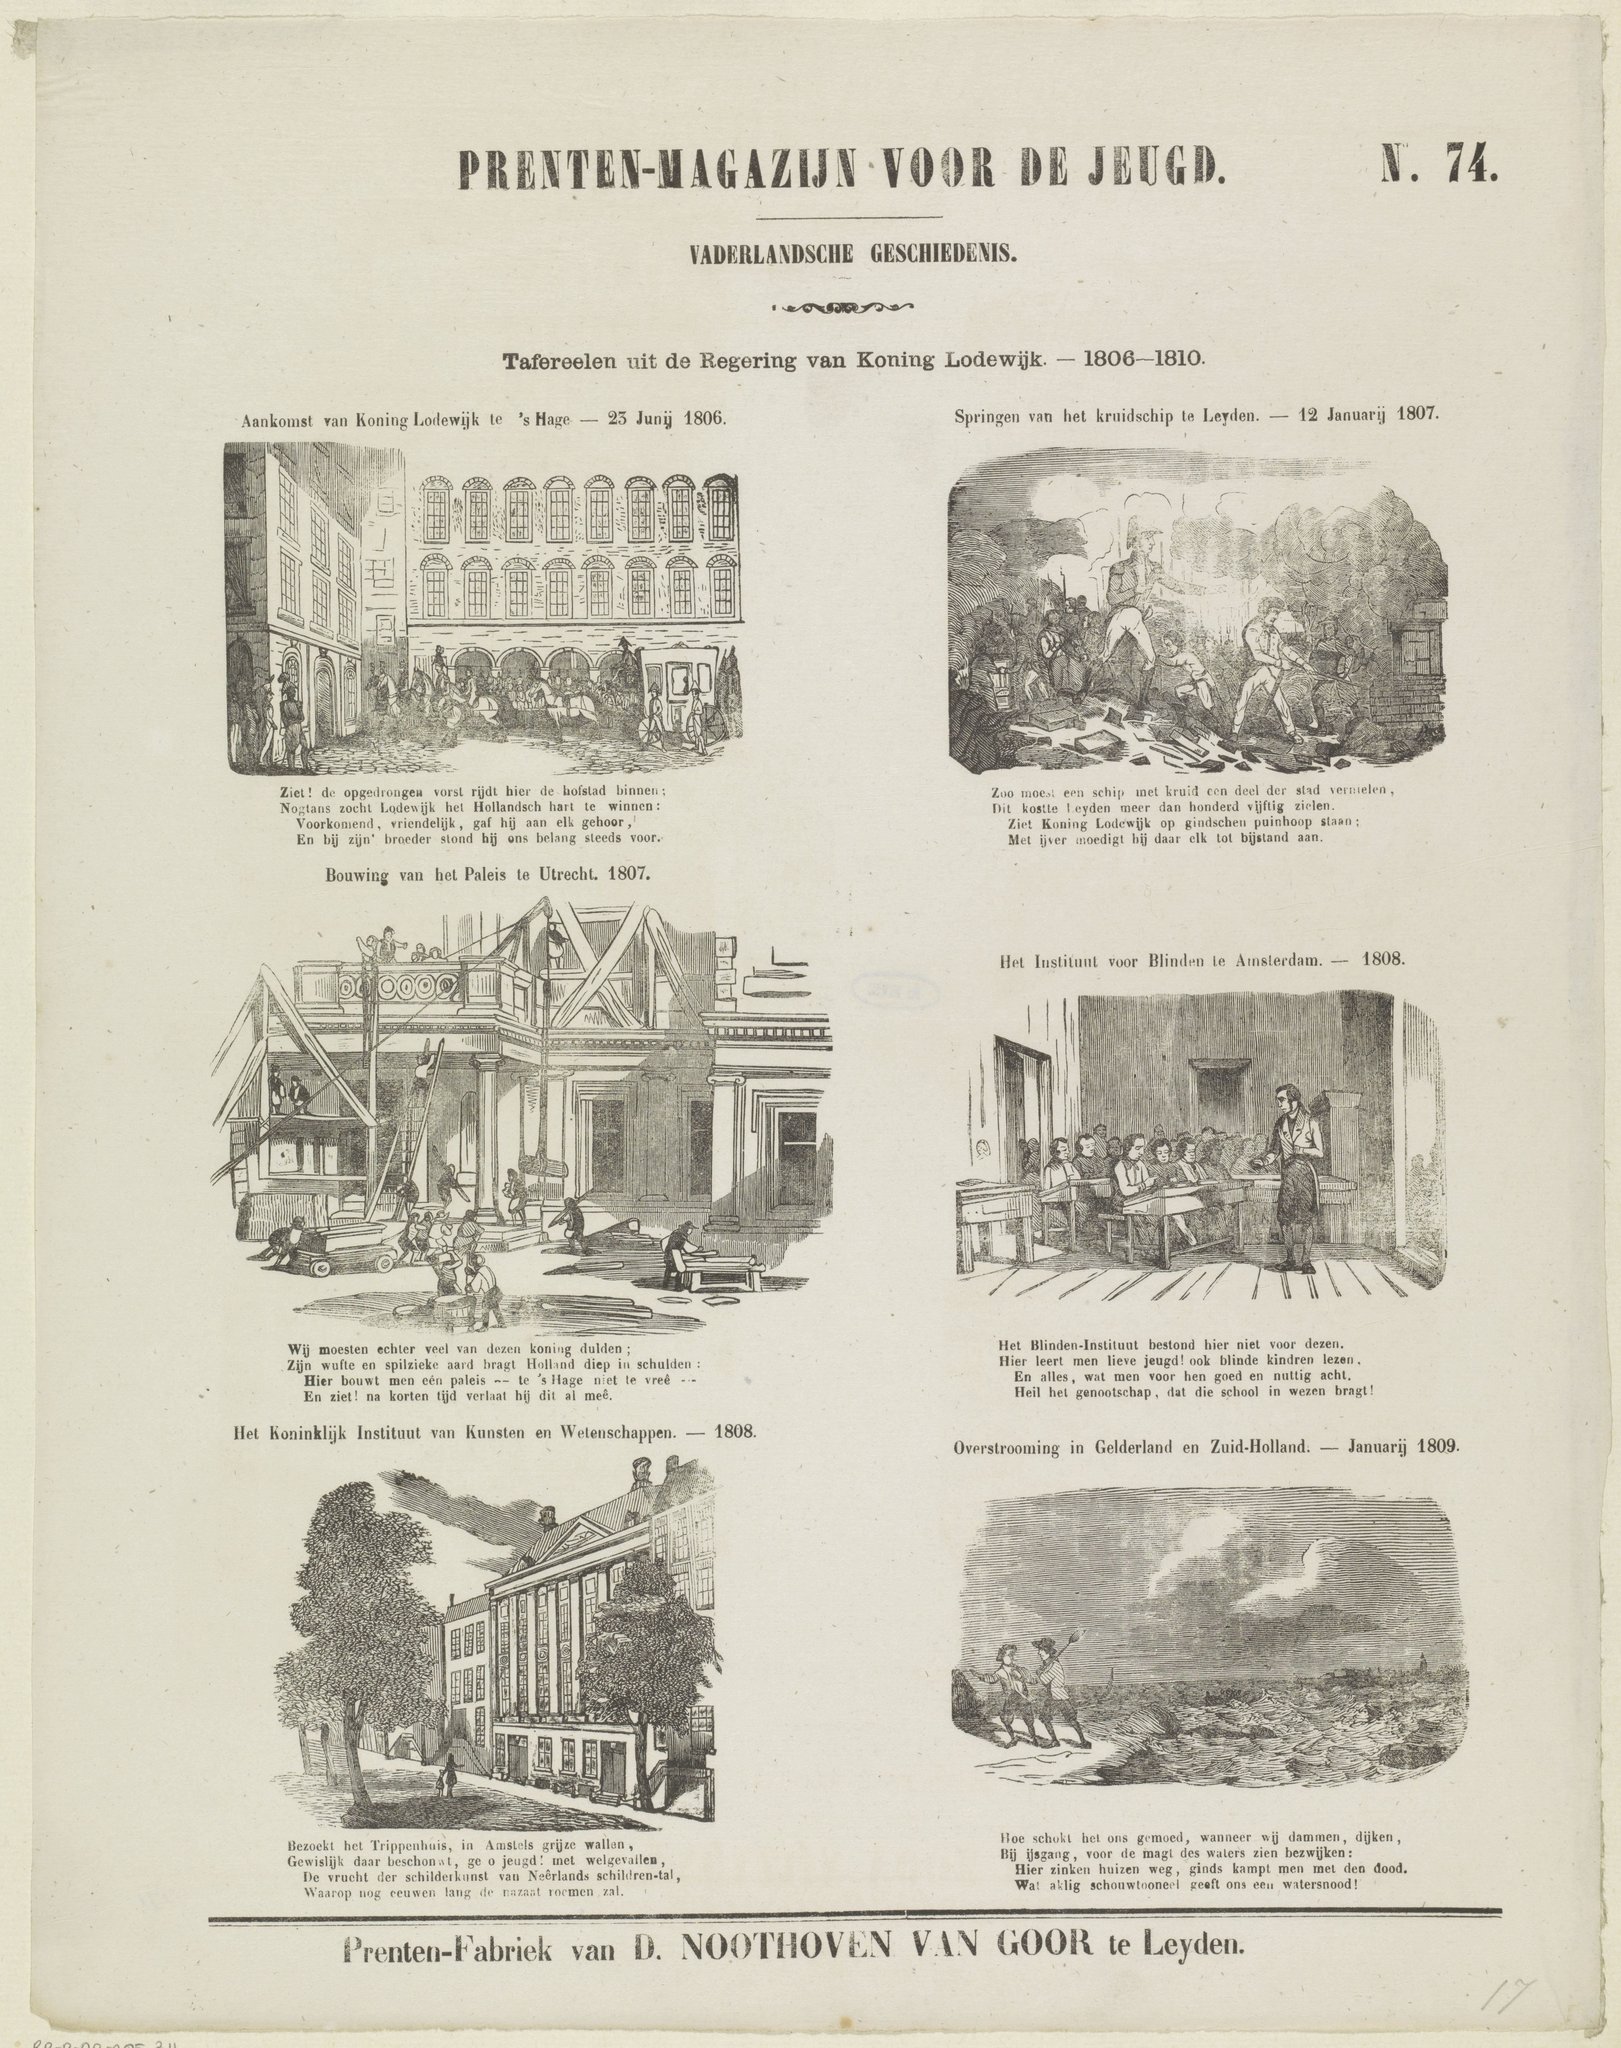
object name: popular print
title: Tafereelen uit de regering van koning Lodewijk. - 1806-1810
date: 1850-1881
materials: paper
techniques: letterpress printing, engraving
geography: netherlands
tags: louis napoleon (king of holland), history, leiden, the hague, utrecht, amsterdam, gelderland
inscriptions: collector's mark: Lugt 2228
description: Blad met 6 voorstellingen van gebeurtenissen ten tijde van de regering van Lodewijk Napoleon tussen 1806 en 1810. Boven elke voorstelling een titel en onder elke voorstelling een vierregelig vers. Genummerd rechtsboven: No. 74.